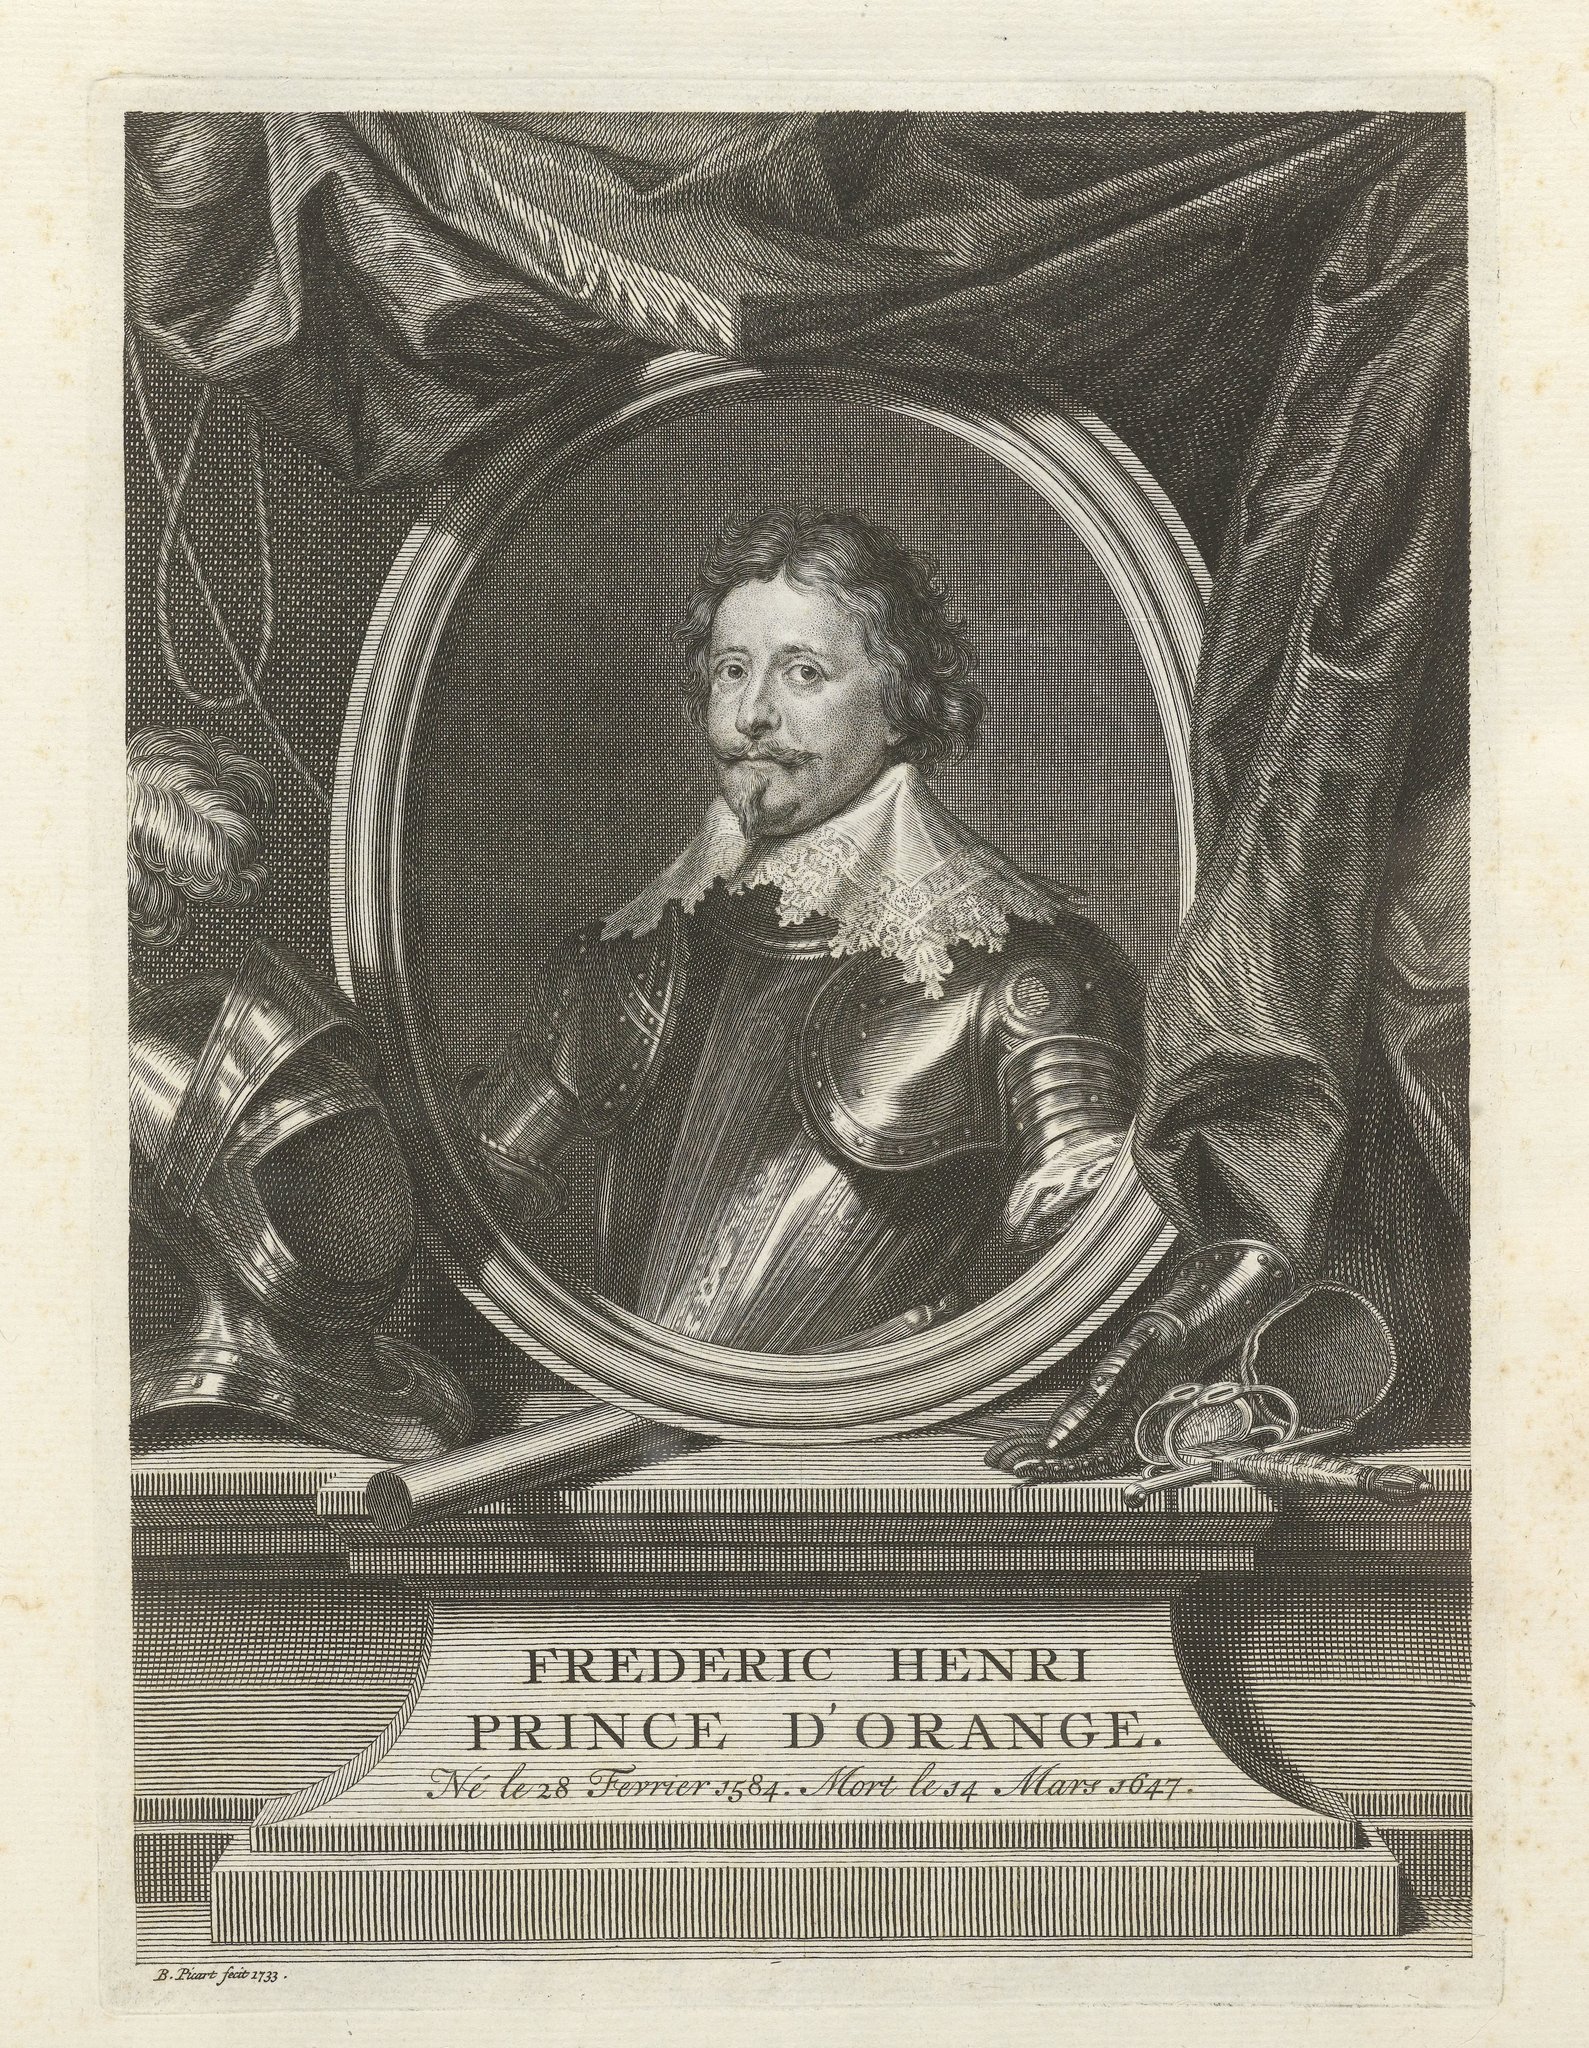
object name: print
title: Portret van Frederik Hendrik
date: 1733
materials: paper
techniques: etching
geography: northern netherlands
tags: frederick henry (prince of orange)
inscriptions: date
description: Portret van Frederik Hendrik, ten halven lijve in ovaal naar links. Aan weerszijden van het portret liggen delen van een wapenrusting.